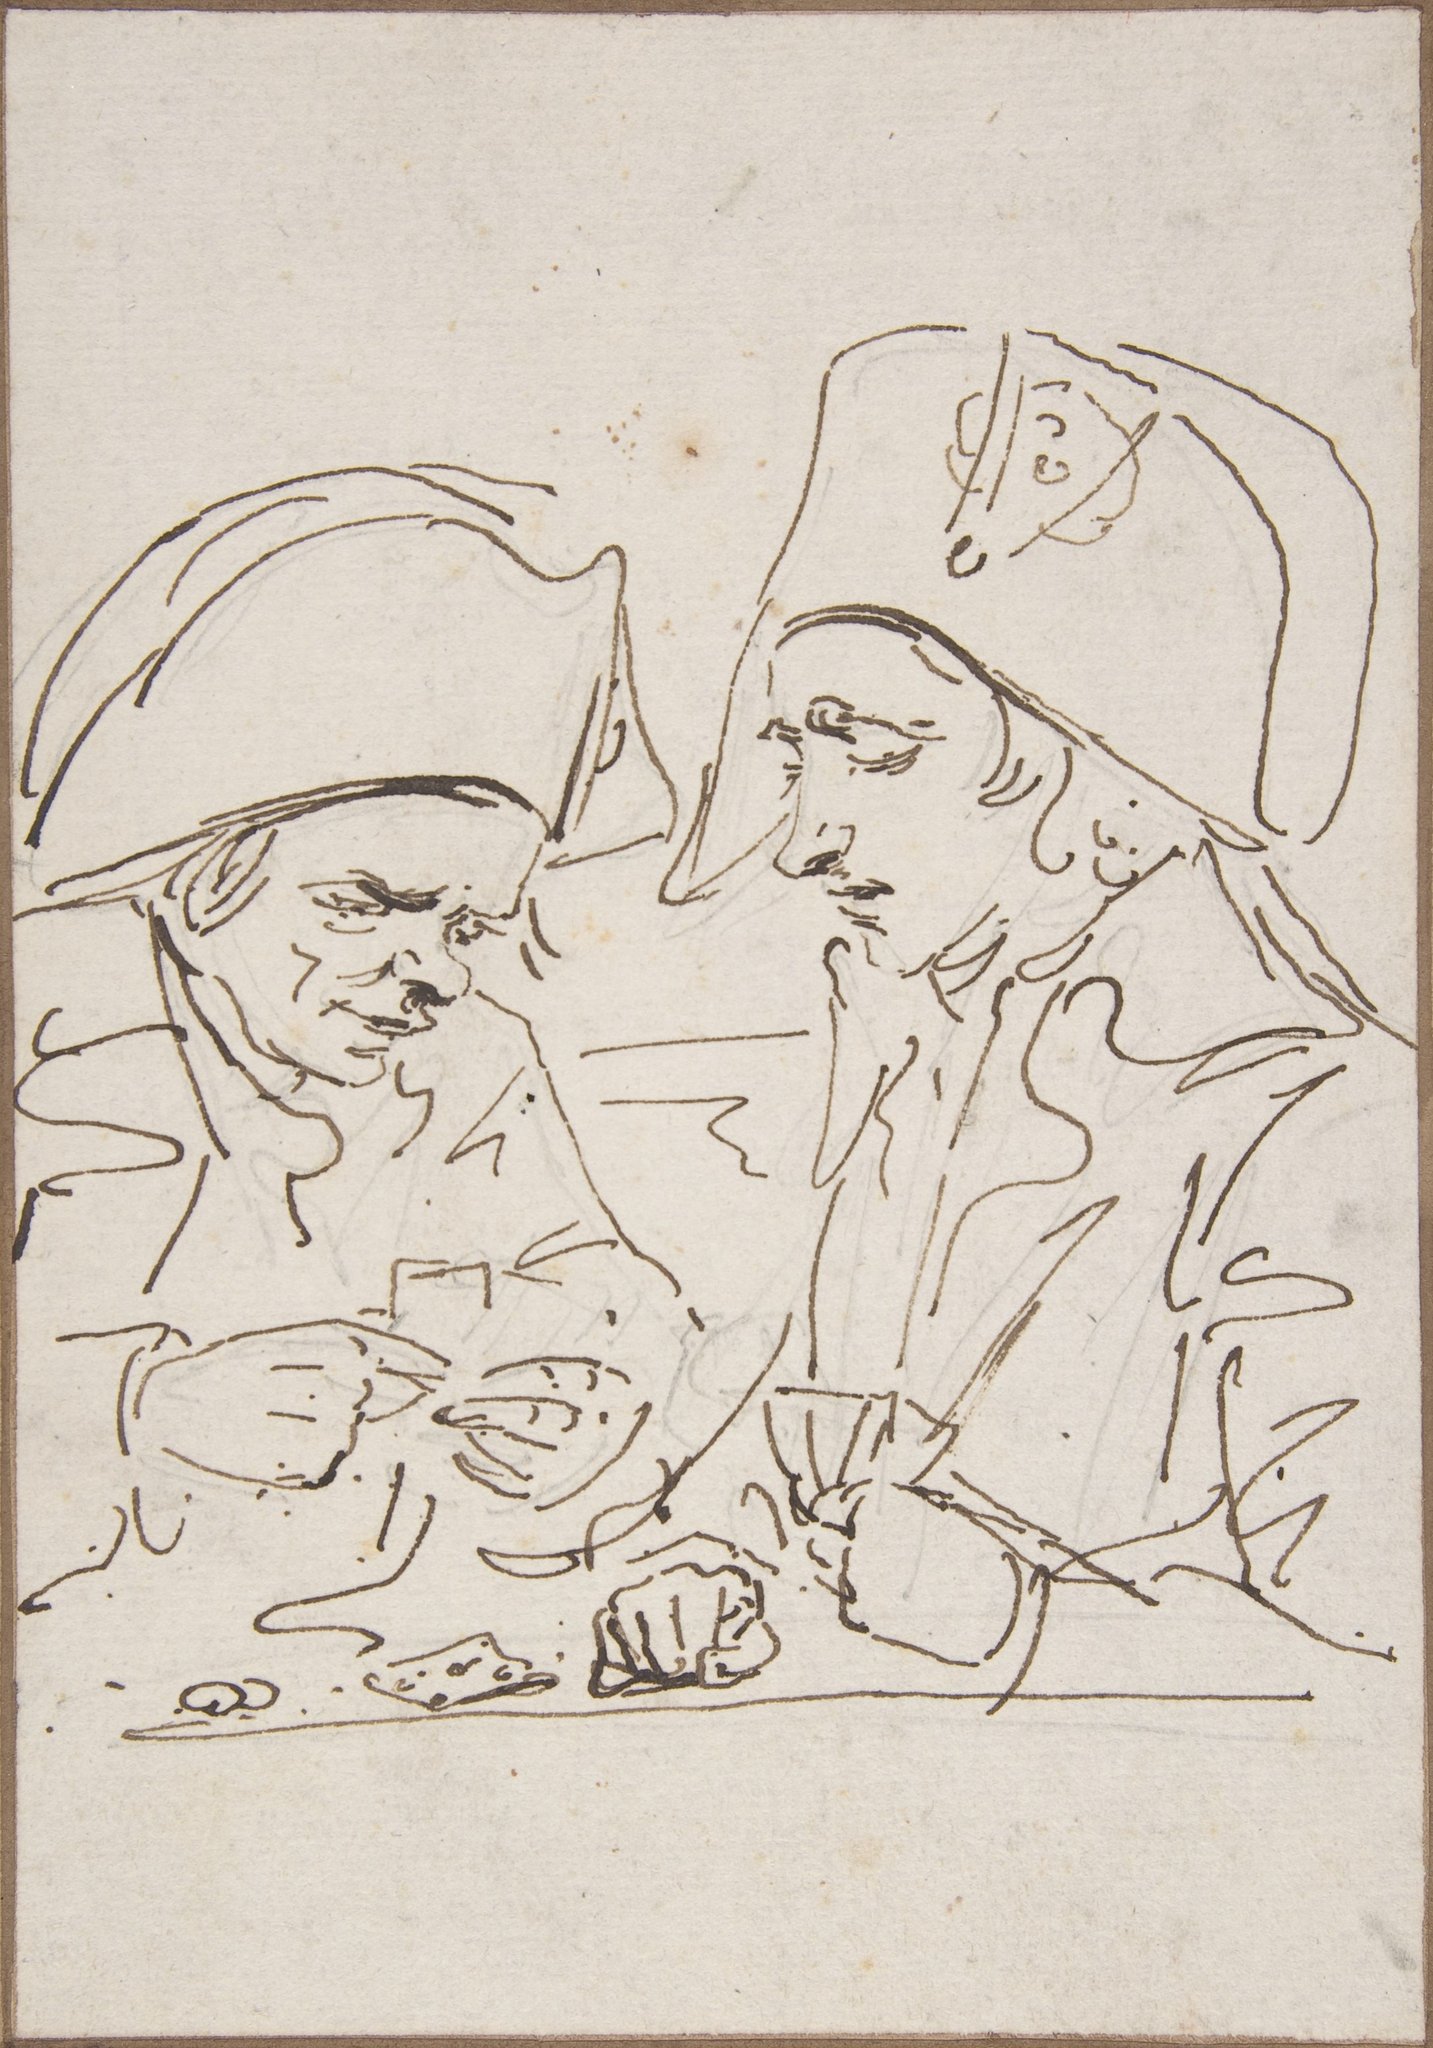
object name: drawing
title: Replacements in the Parisian Guard Playing Cards in 1795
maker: baron dominique vivant denon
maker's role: artist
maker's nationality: french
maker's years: 1747-1825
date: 1795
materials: chalk, ink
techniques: pen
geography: france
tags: men,playing cards